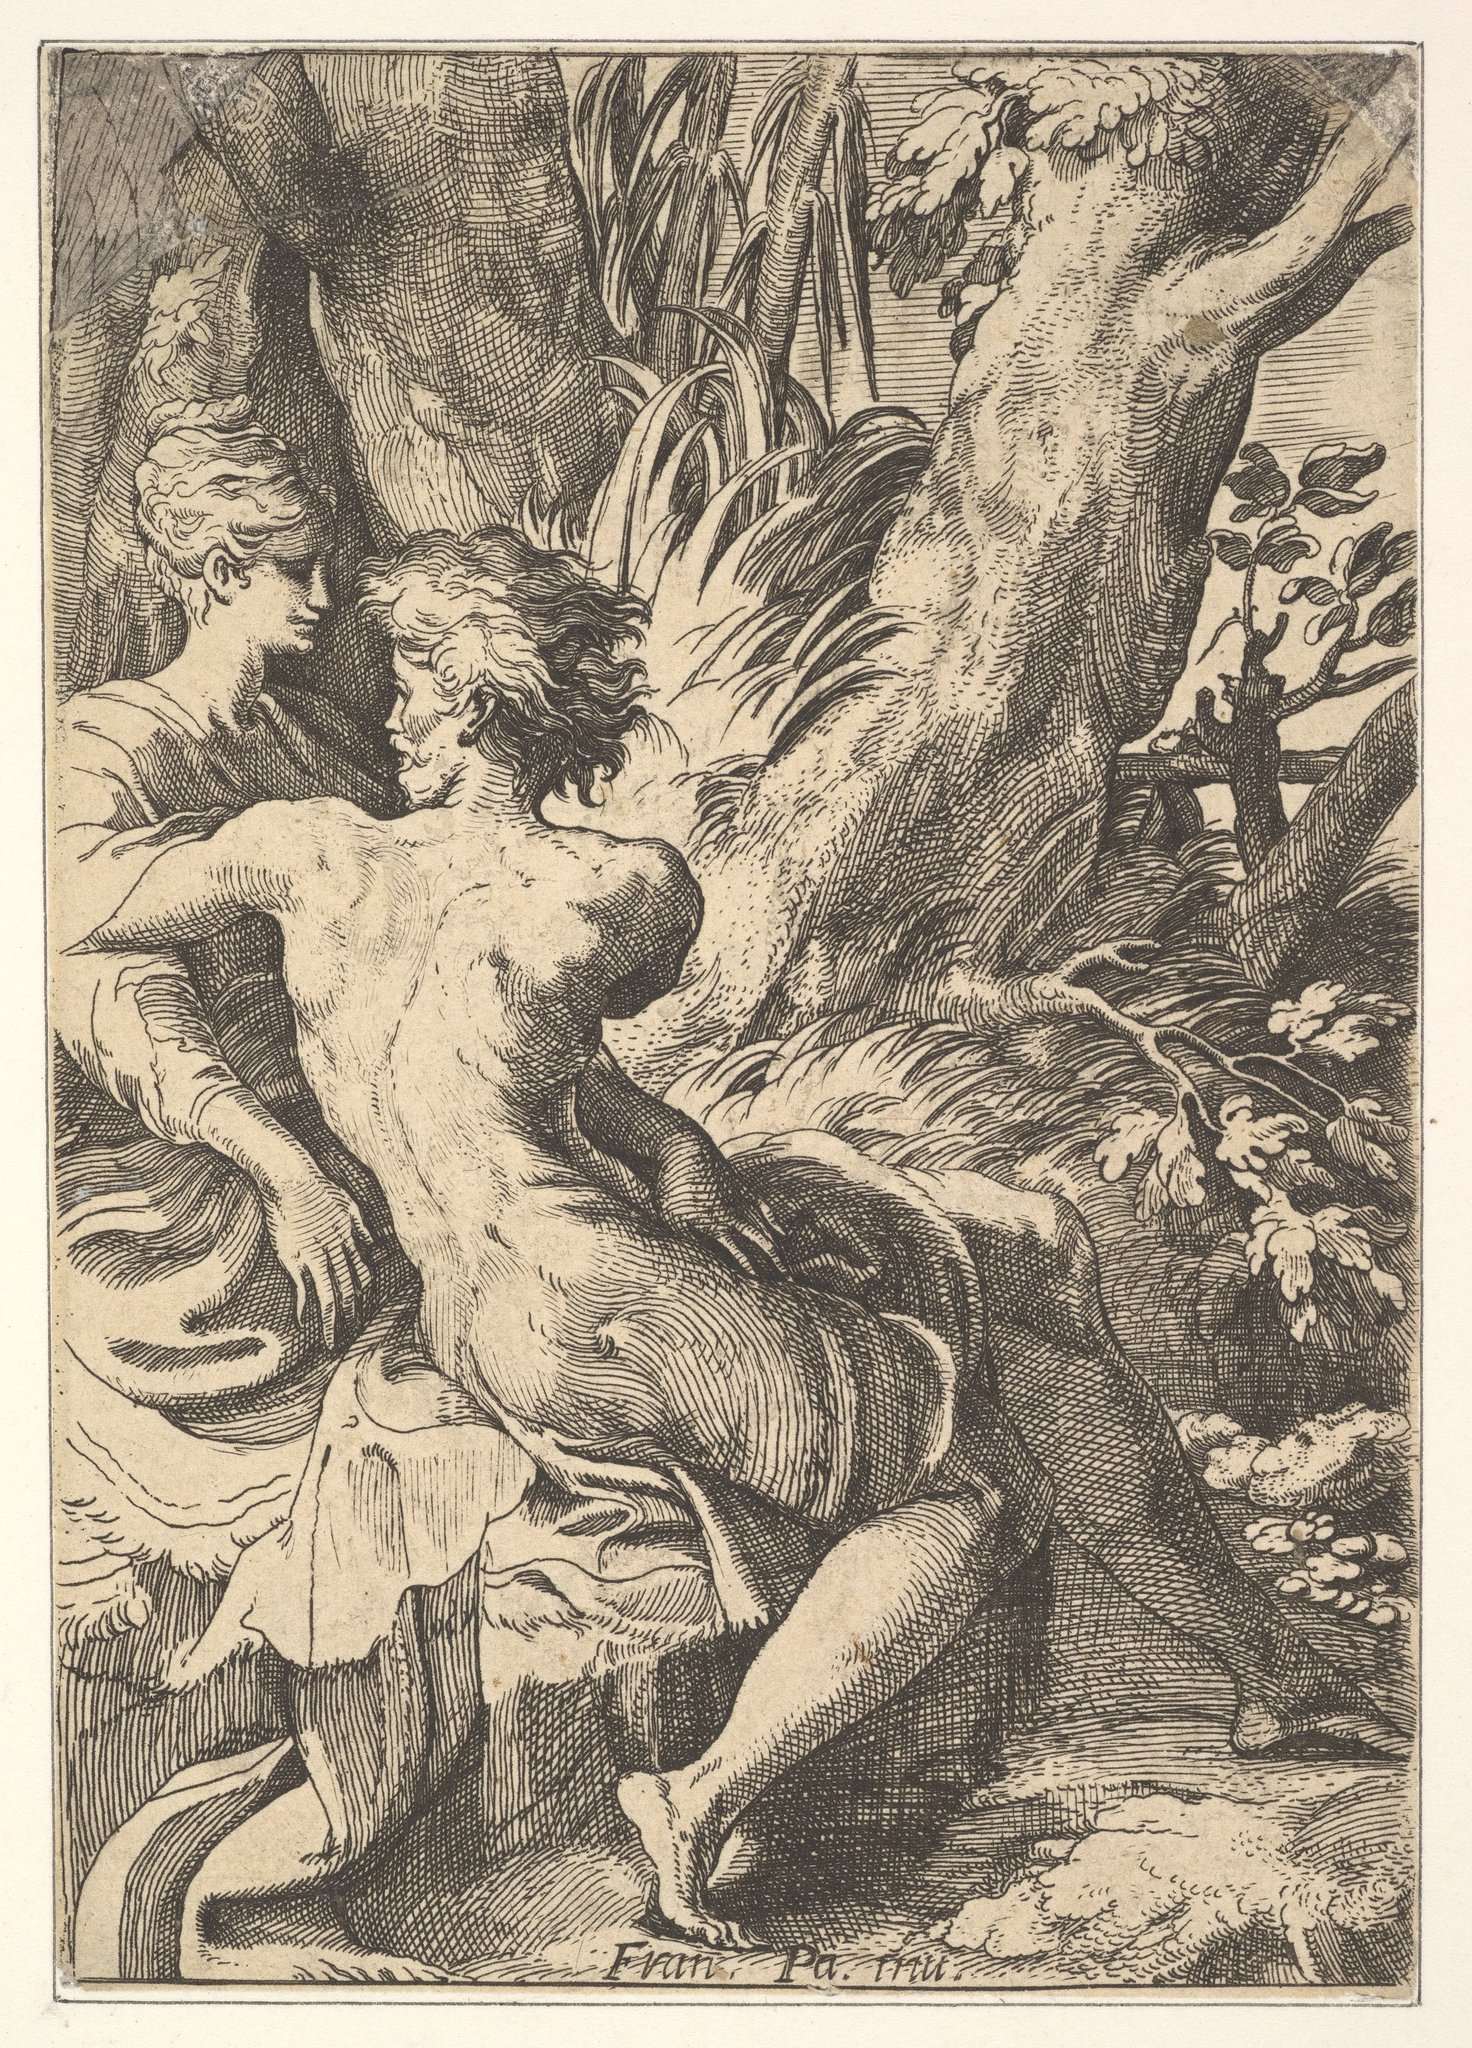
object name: print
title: The Lovers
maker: anonymous, italian, 17th century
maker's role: artist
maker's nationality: italian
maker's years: 1600-1700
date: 1601-1700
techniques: etching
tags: men,lovers,women